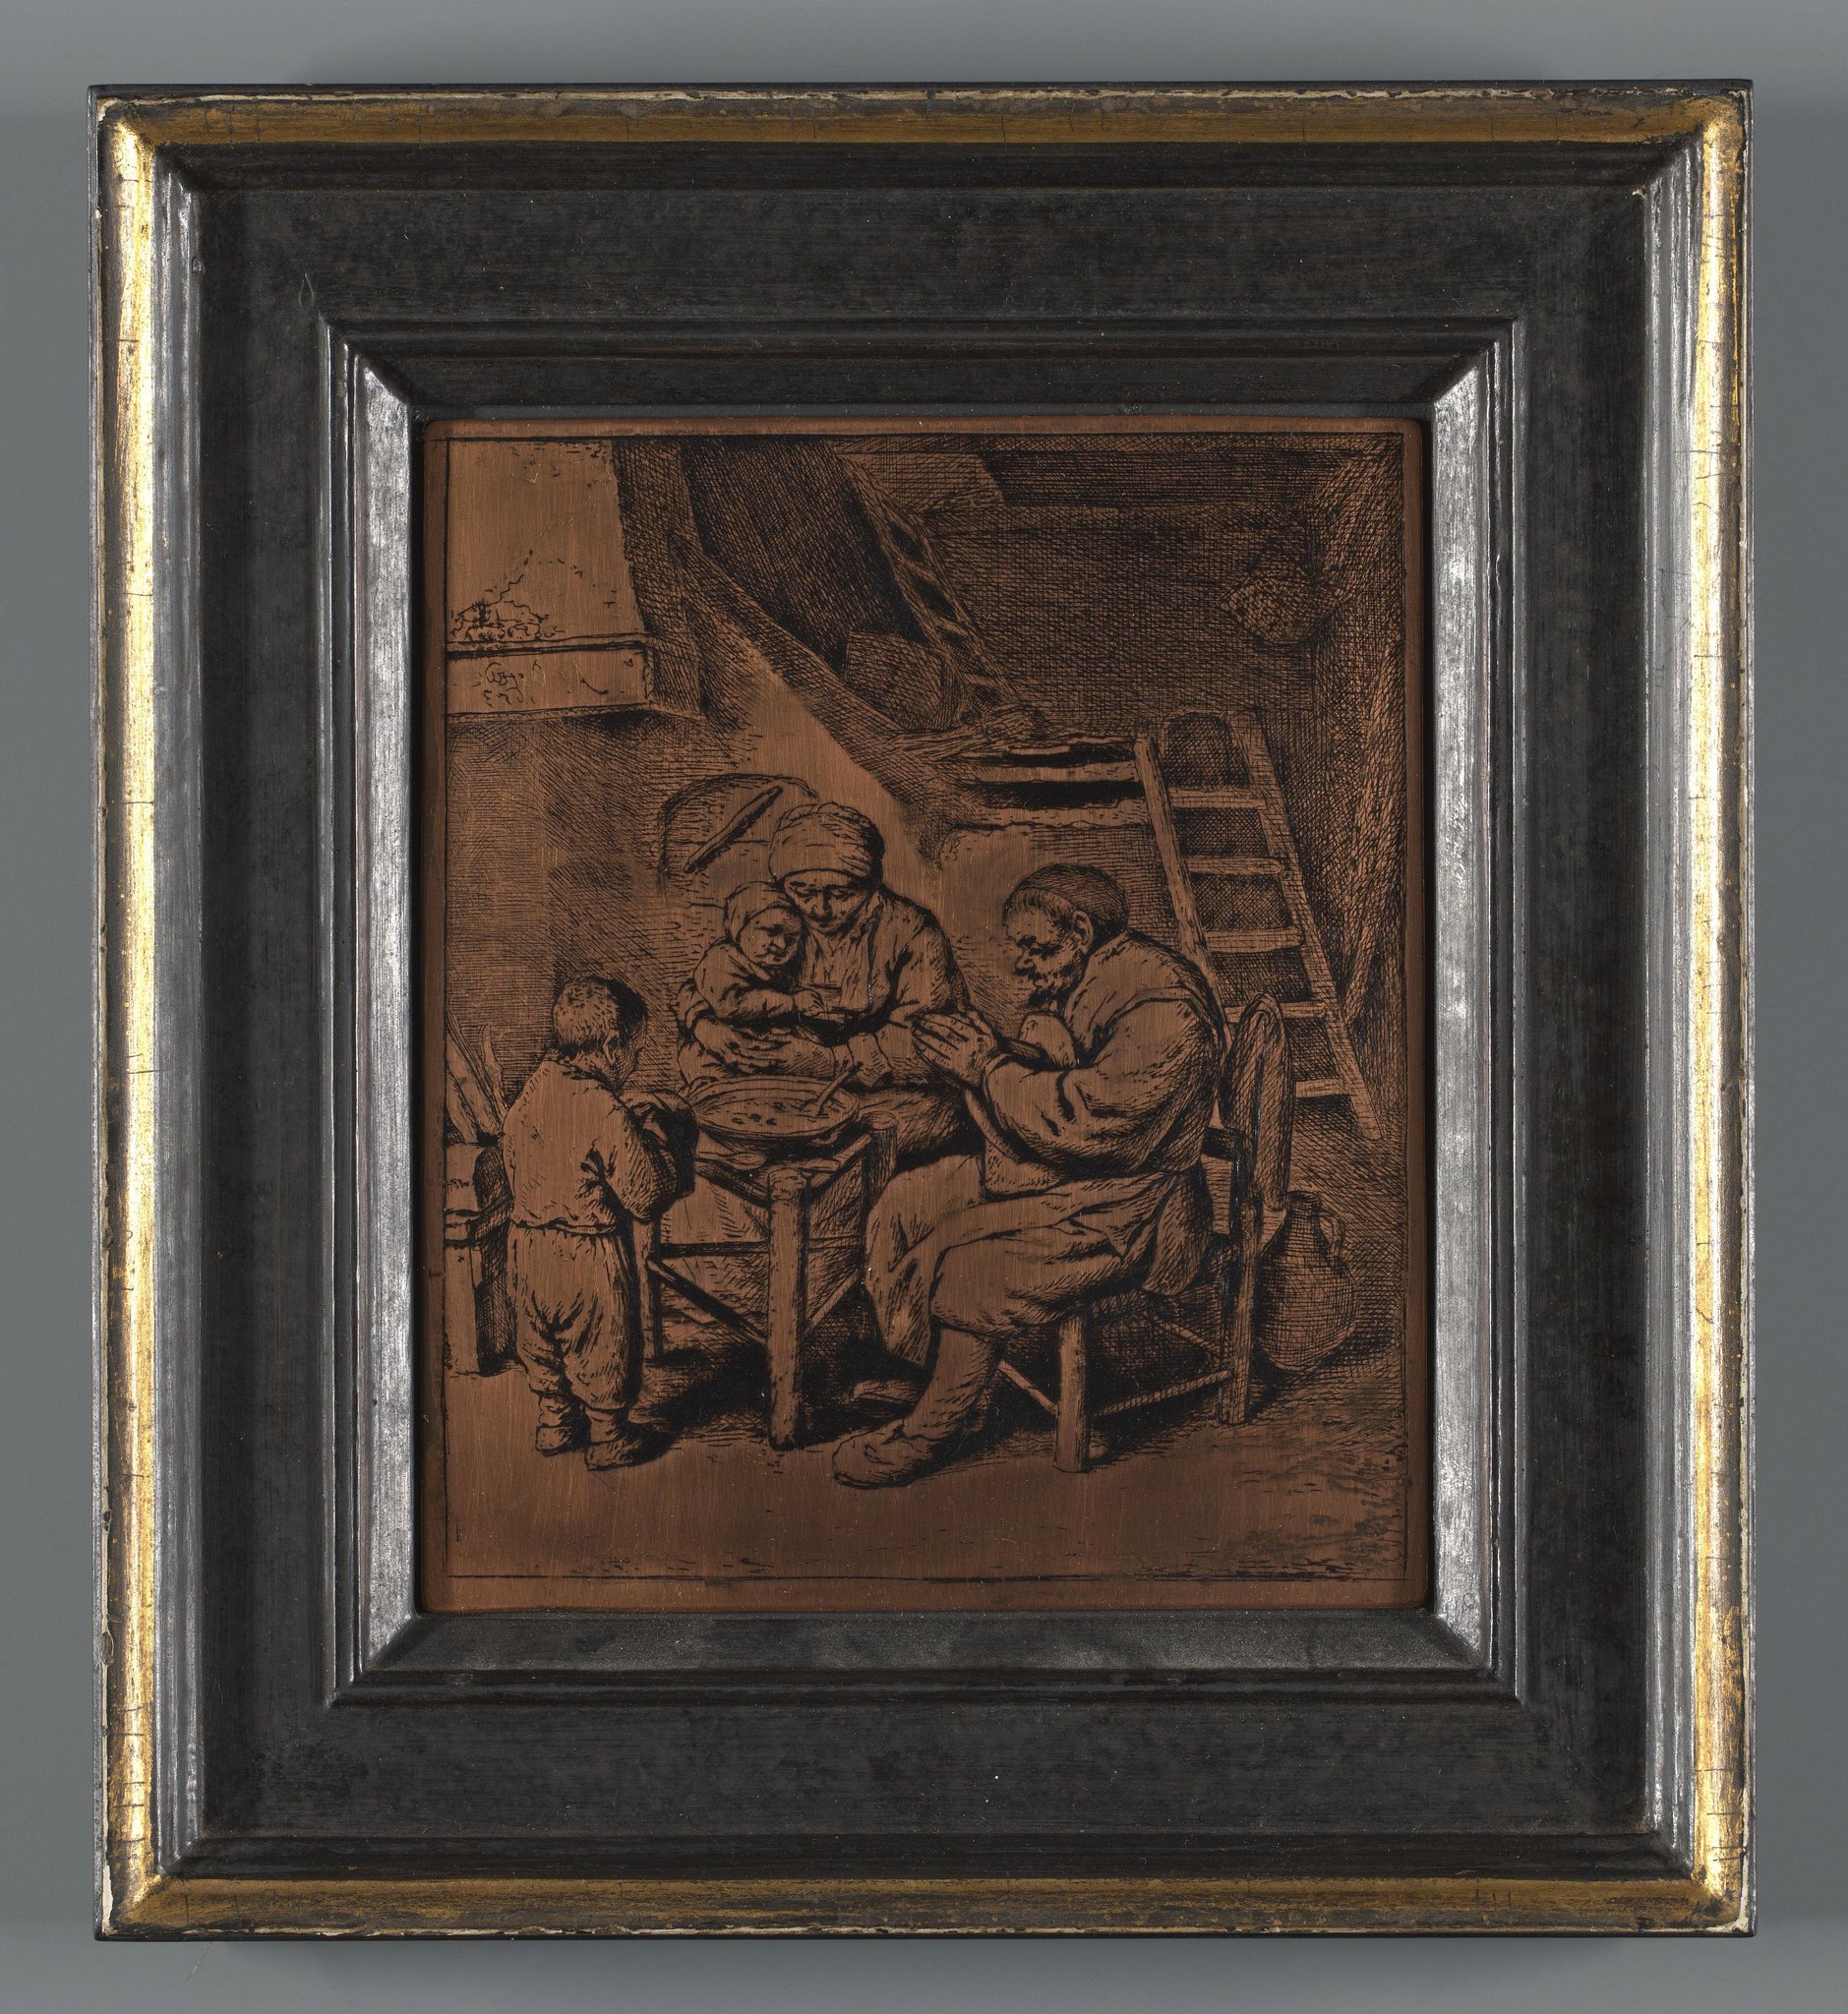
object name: copper plate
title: Gezin aan tafel voor de maaltijd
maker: adriaen van ostade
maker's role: draughtsman, painter, print maker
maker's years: 1610-1685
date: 1653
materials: copper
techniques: engraving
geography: haarlem